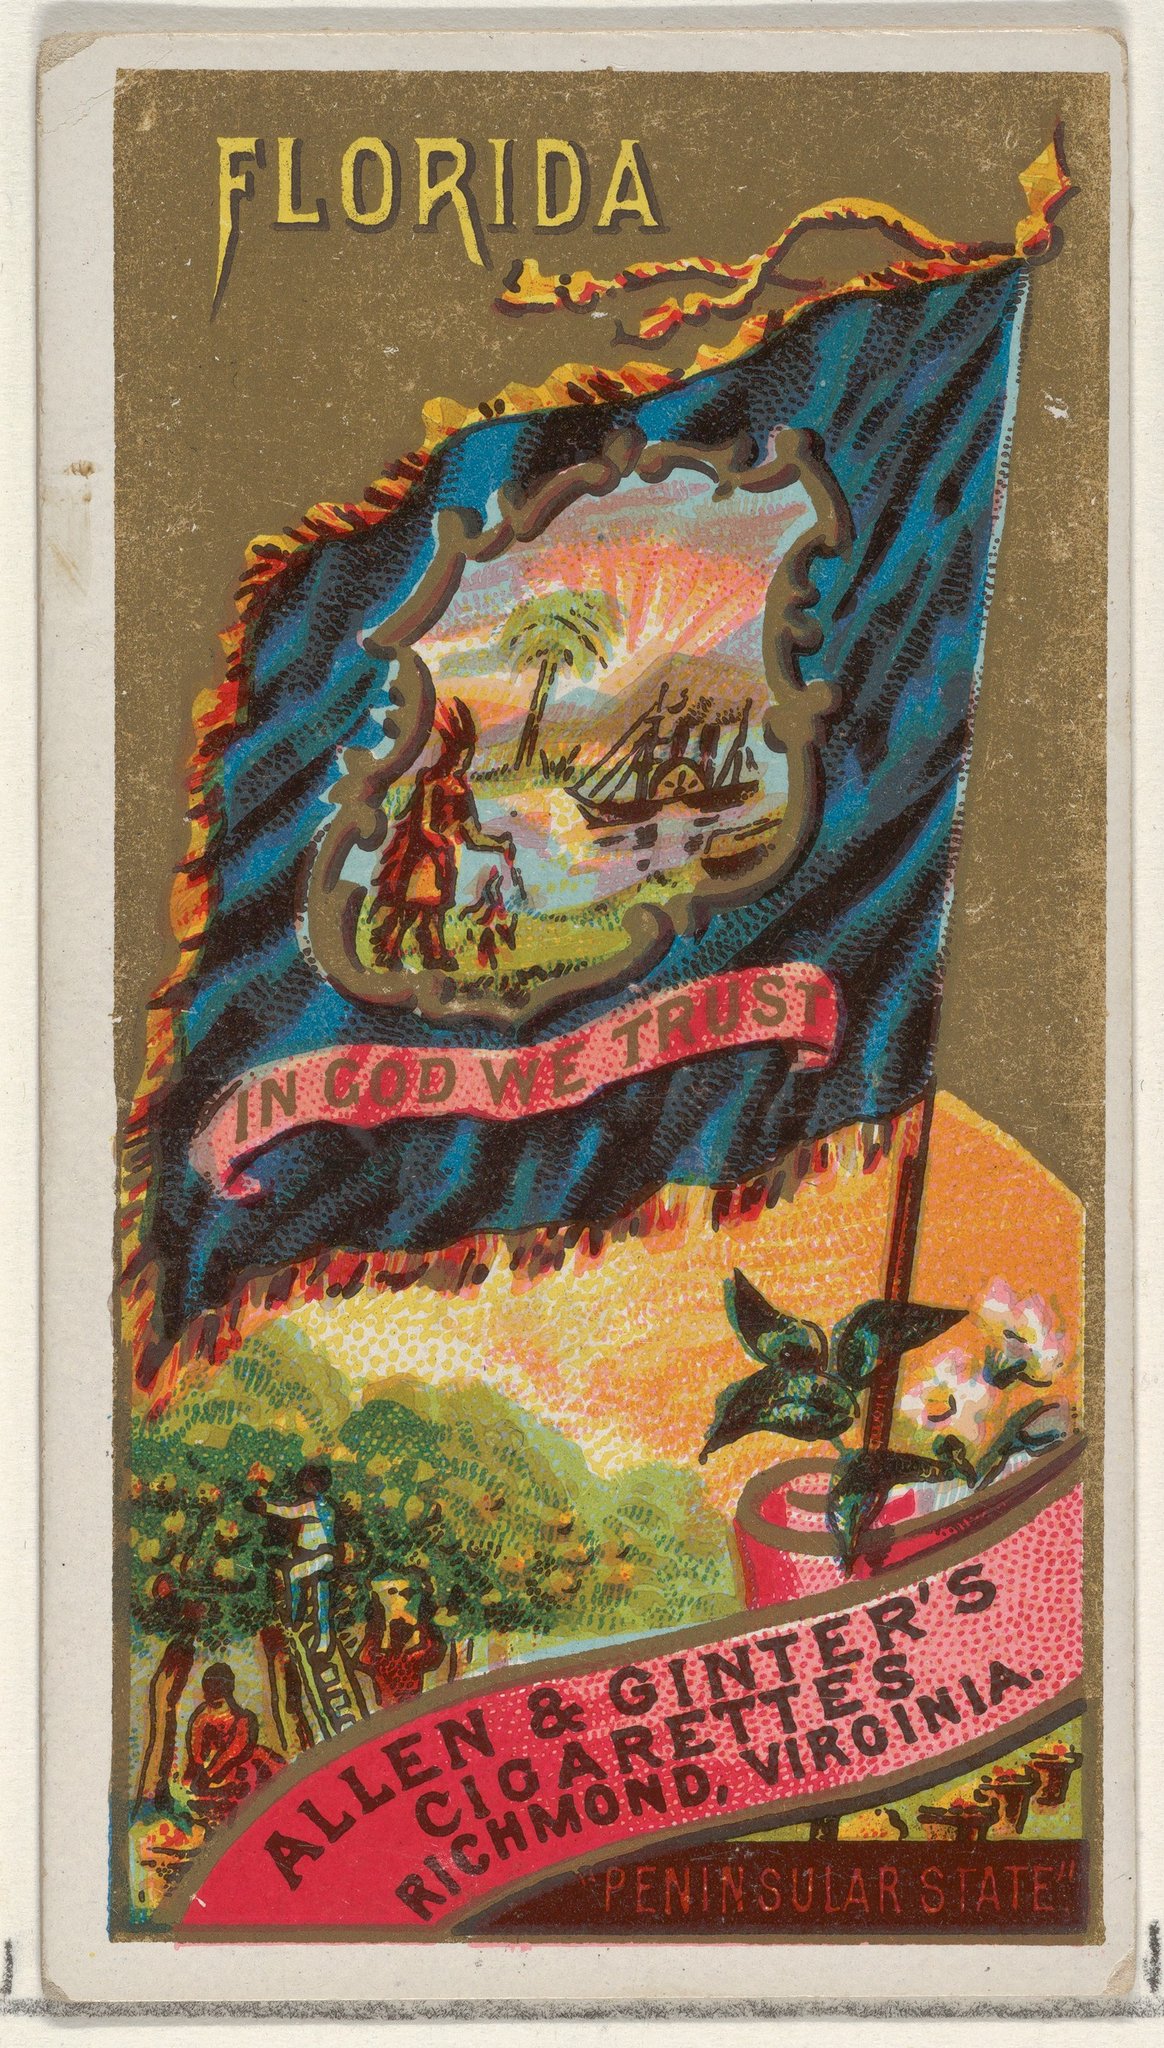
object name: print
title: Florida, from Flags of the States and Territories (N11) for Allen & Ginter Cigarettes Brands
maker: allen & ginter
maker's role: publisher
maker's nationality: american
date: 1888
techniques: color lithograph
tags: flags